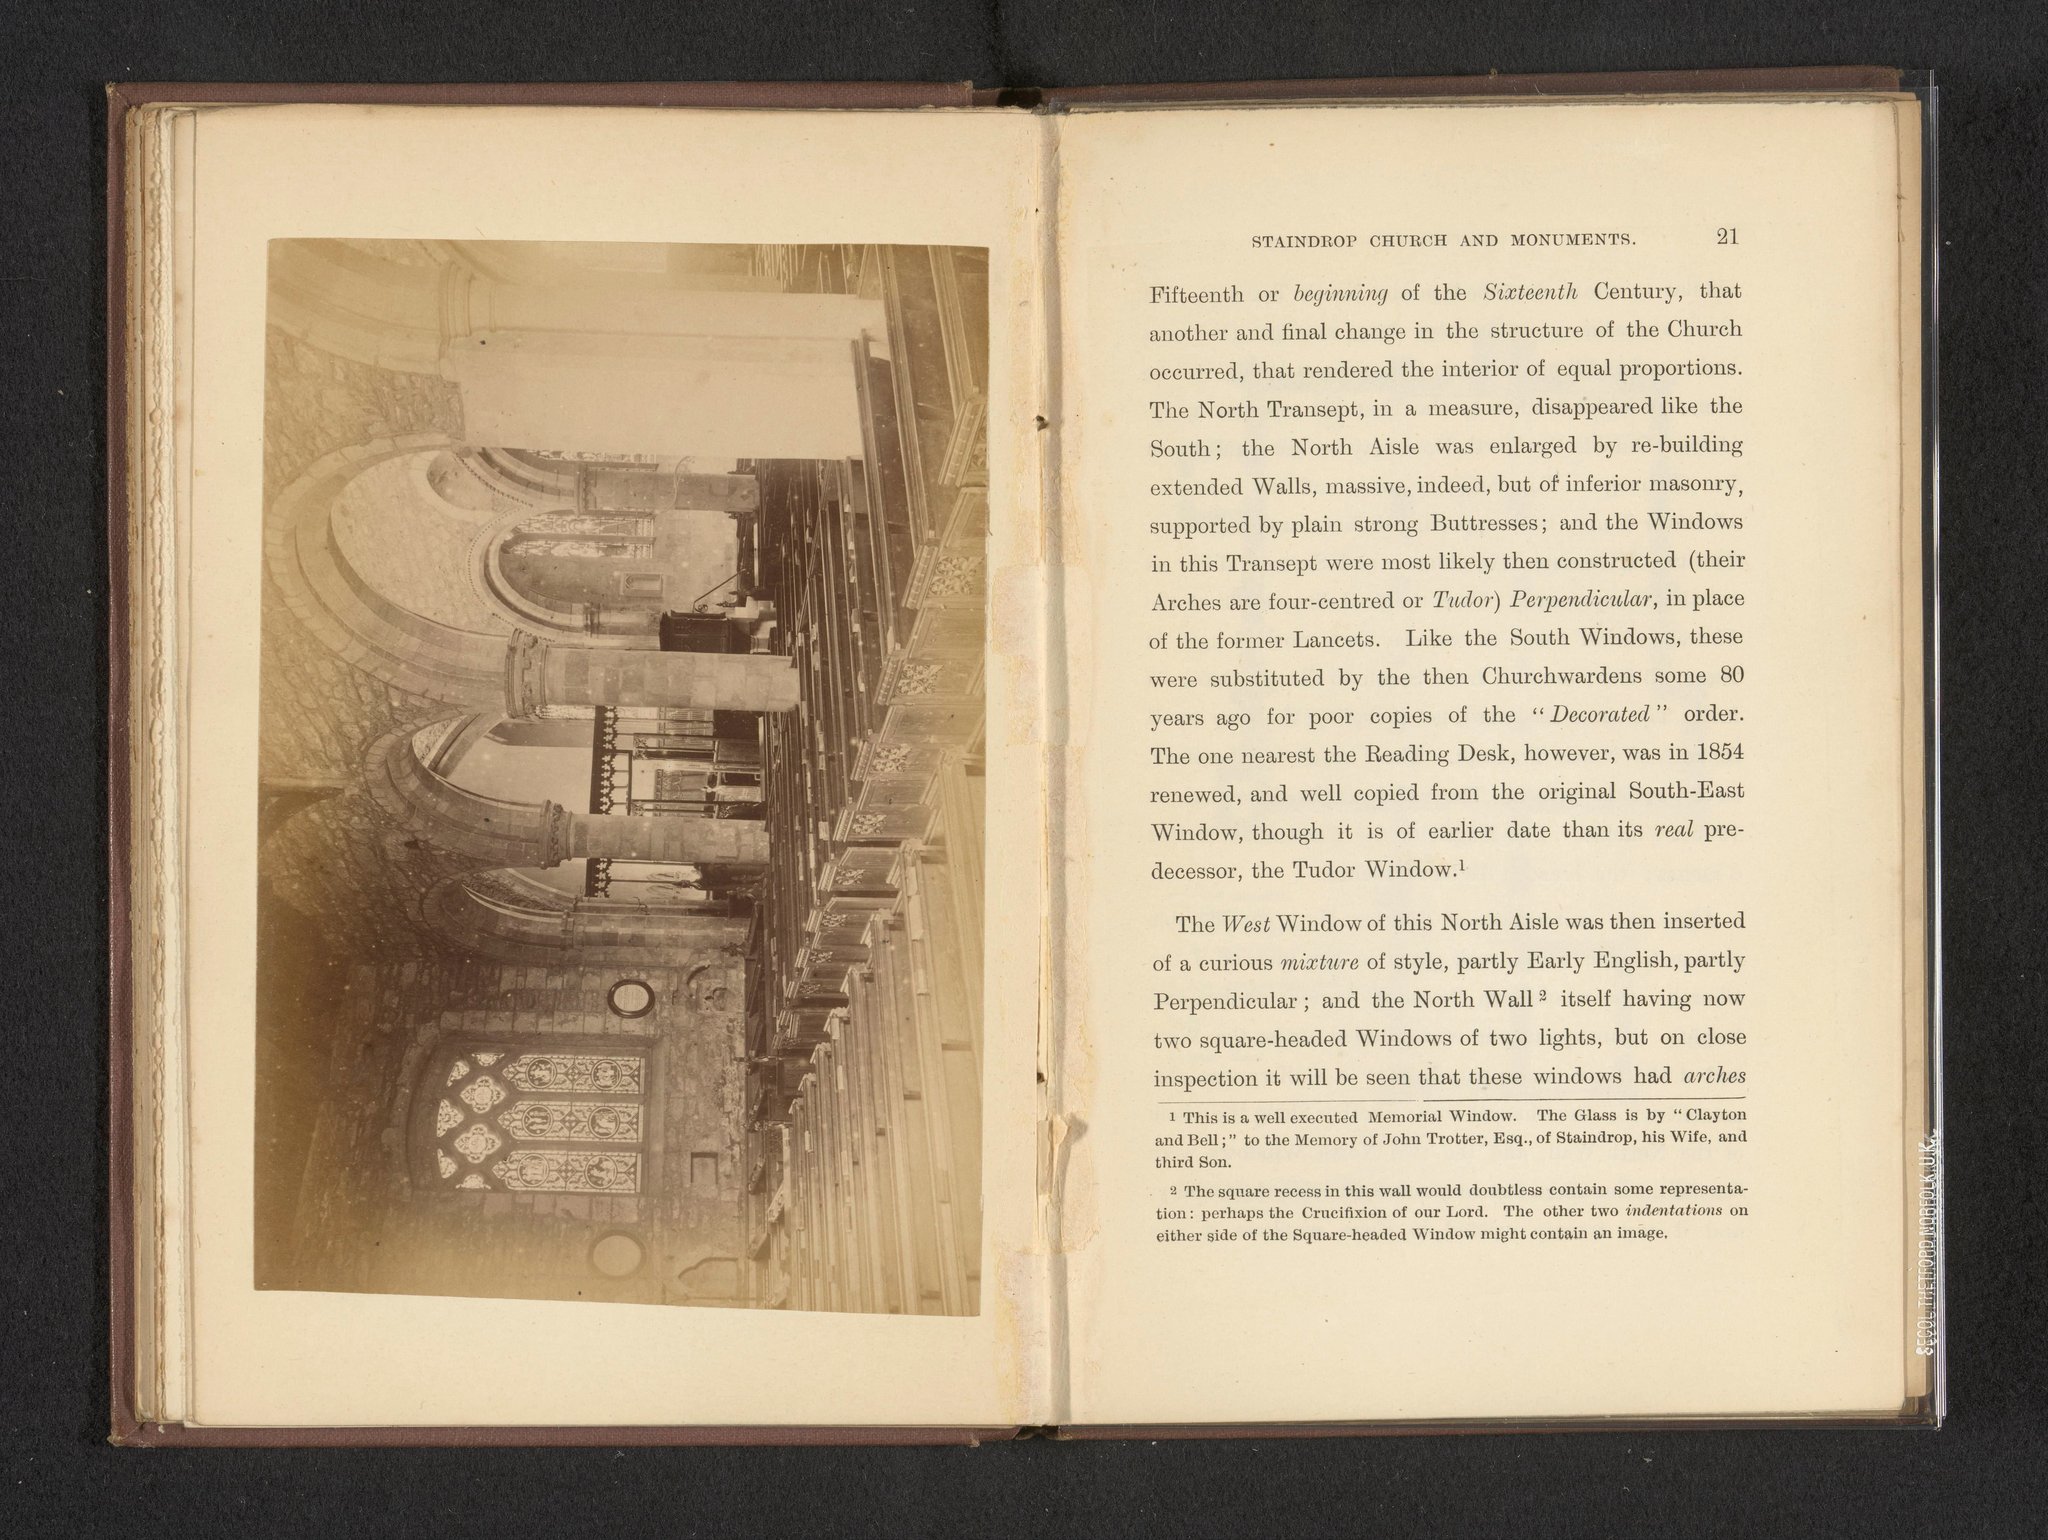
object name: page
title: Koorbanken in Saint Mary's Church te Staindrop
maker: Anonymous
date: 1878-1888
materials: photographic support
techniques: albumen print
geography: saint mary's church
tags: interior of church, seats of the clergy, choir-stalls